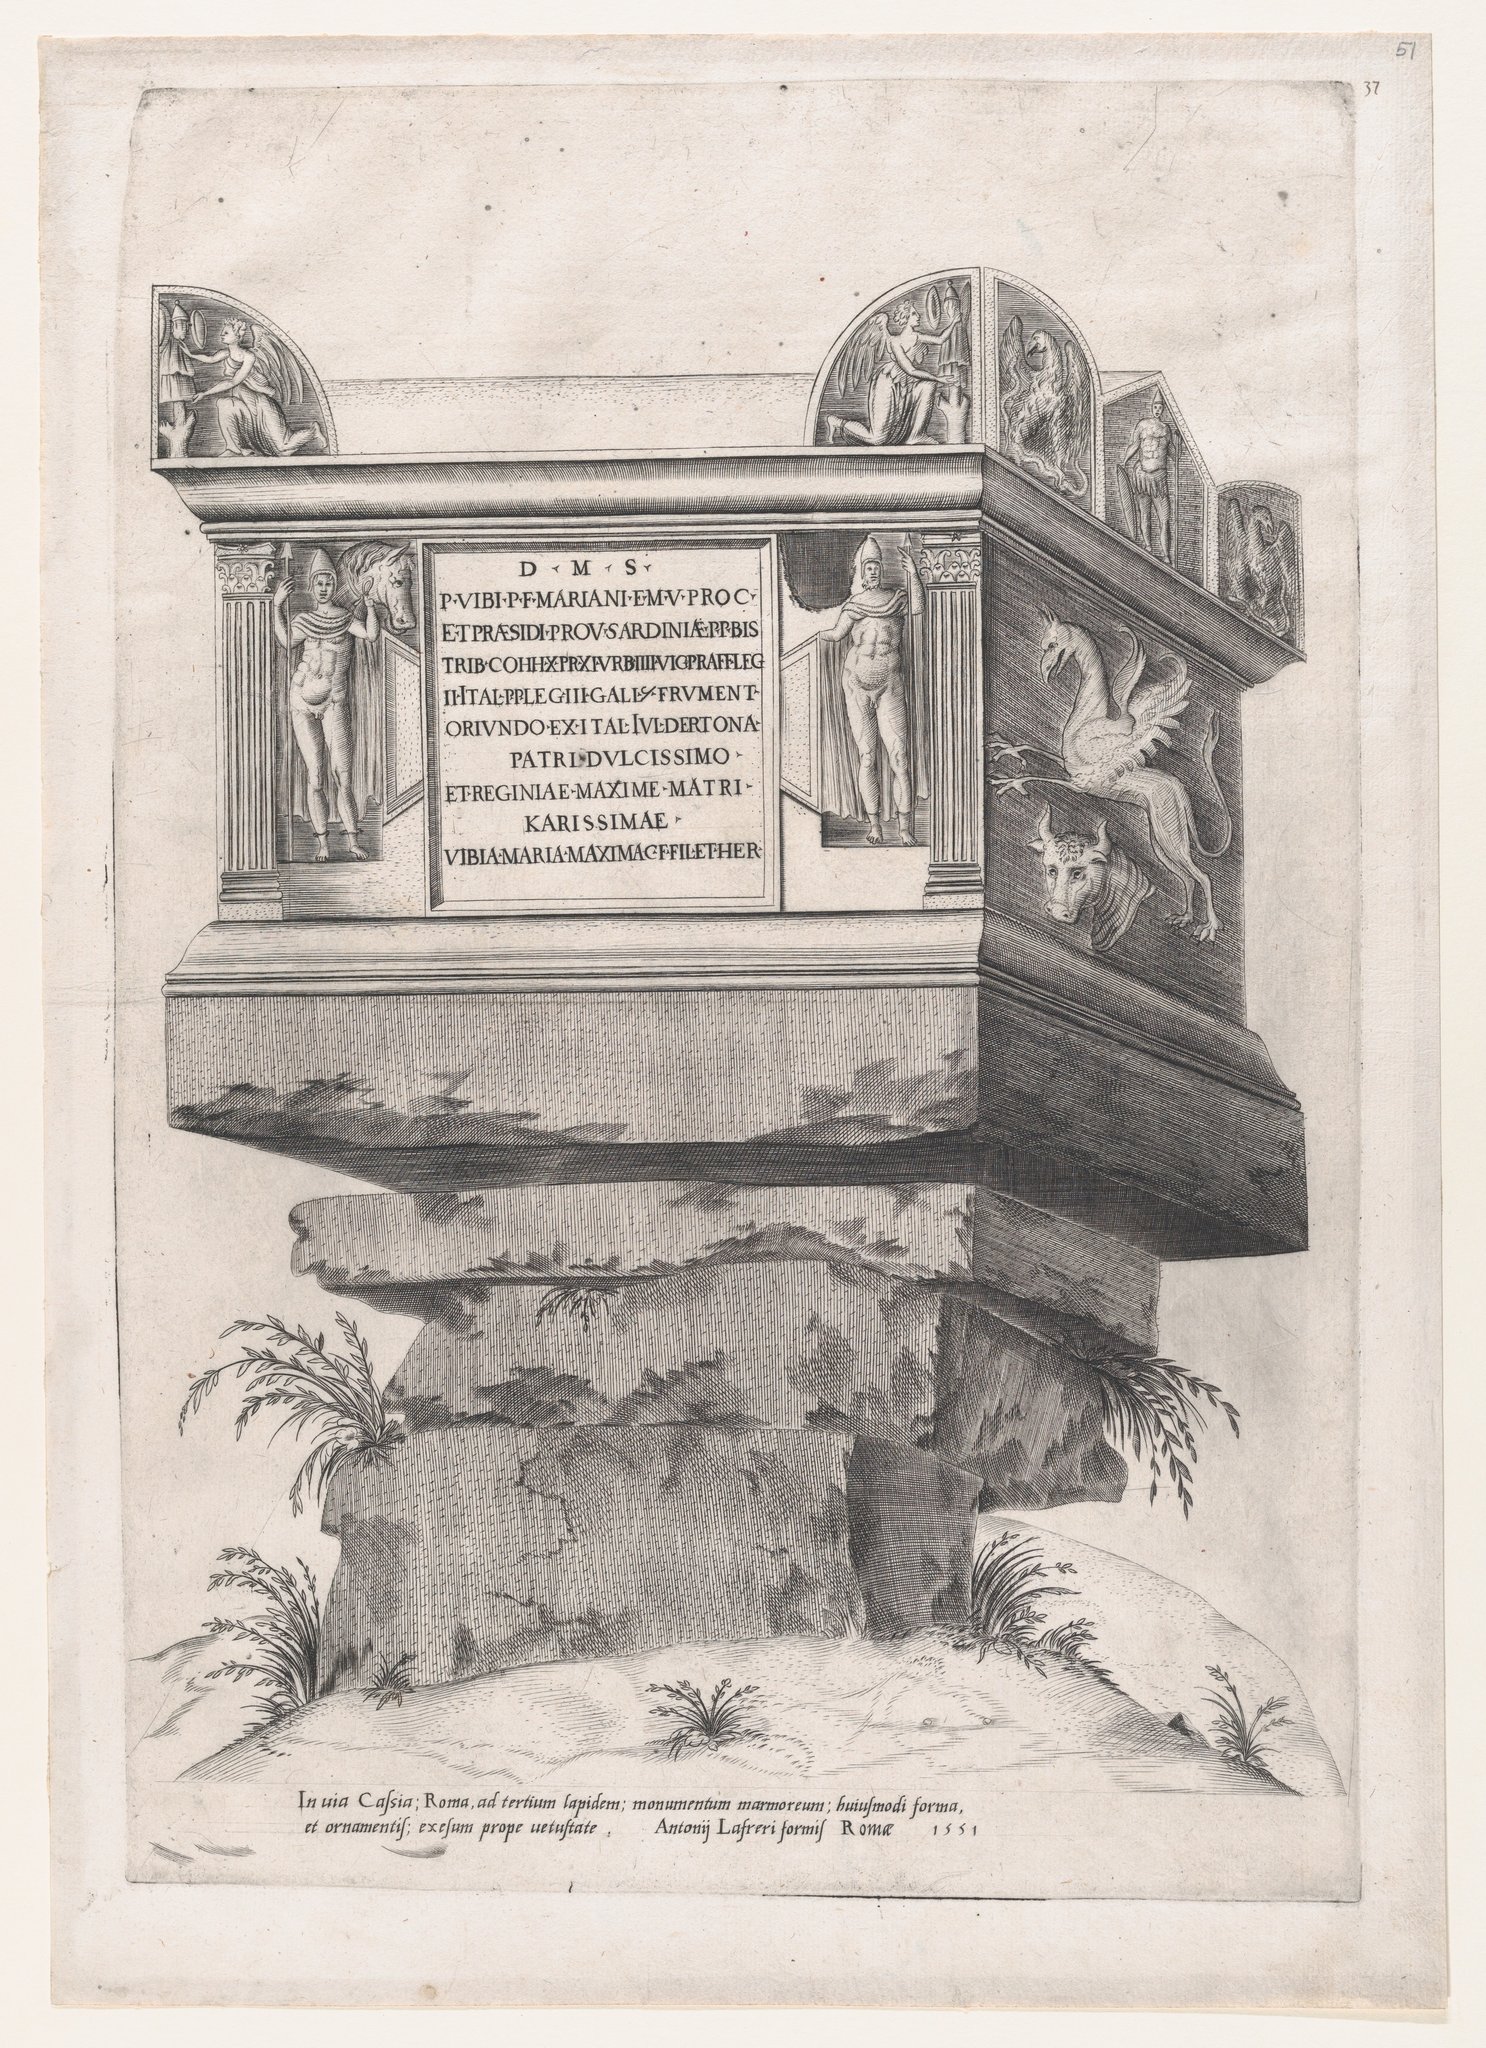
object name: print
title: Sepulchre of Vibius, from "Speculum Romanae Magnificentiae"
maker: Anonymous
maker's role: artist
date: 1551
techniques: engraving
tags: male nudes,rome